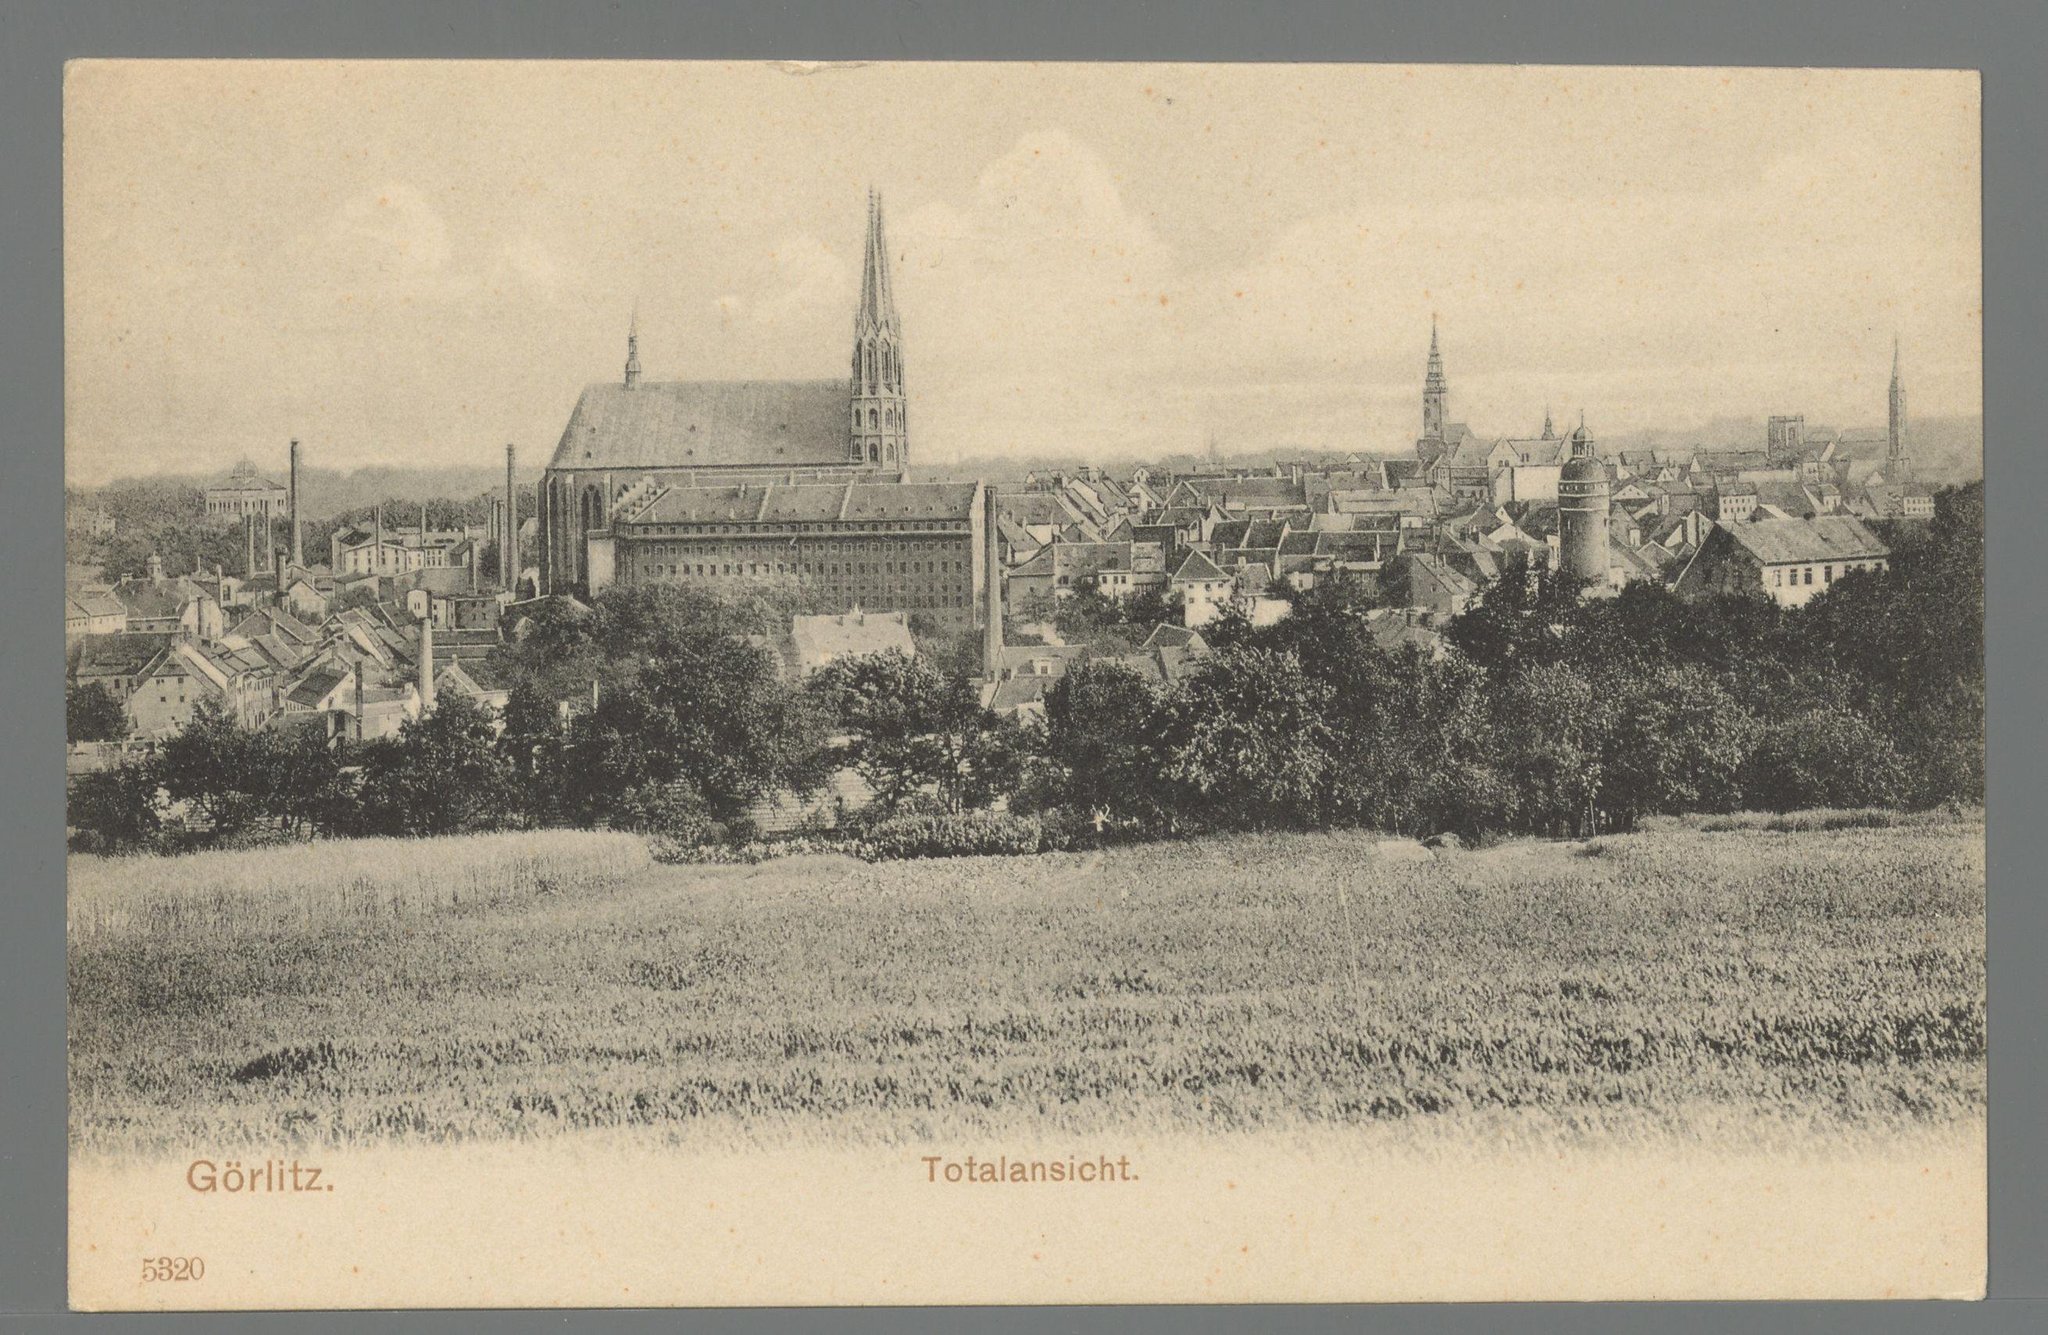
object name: ansichtkaart, prentbriefkaart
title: Görlitz. Totalansicht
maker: Anonymous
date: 1885-1905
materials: cardboard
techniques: photograph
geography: görlitz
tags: city-view, and landscape with man-made constructions, church (exterior)